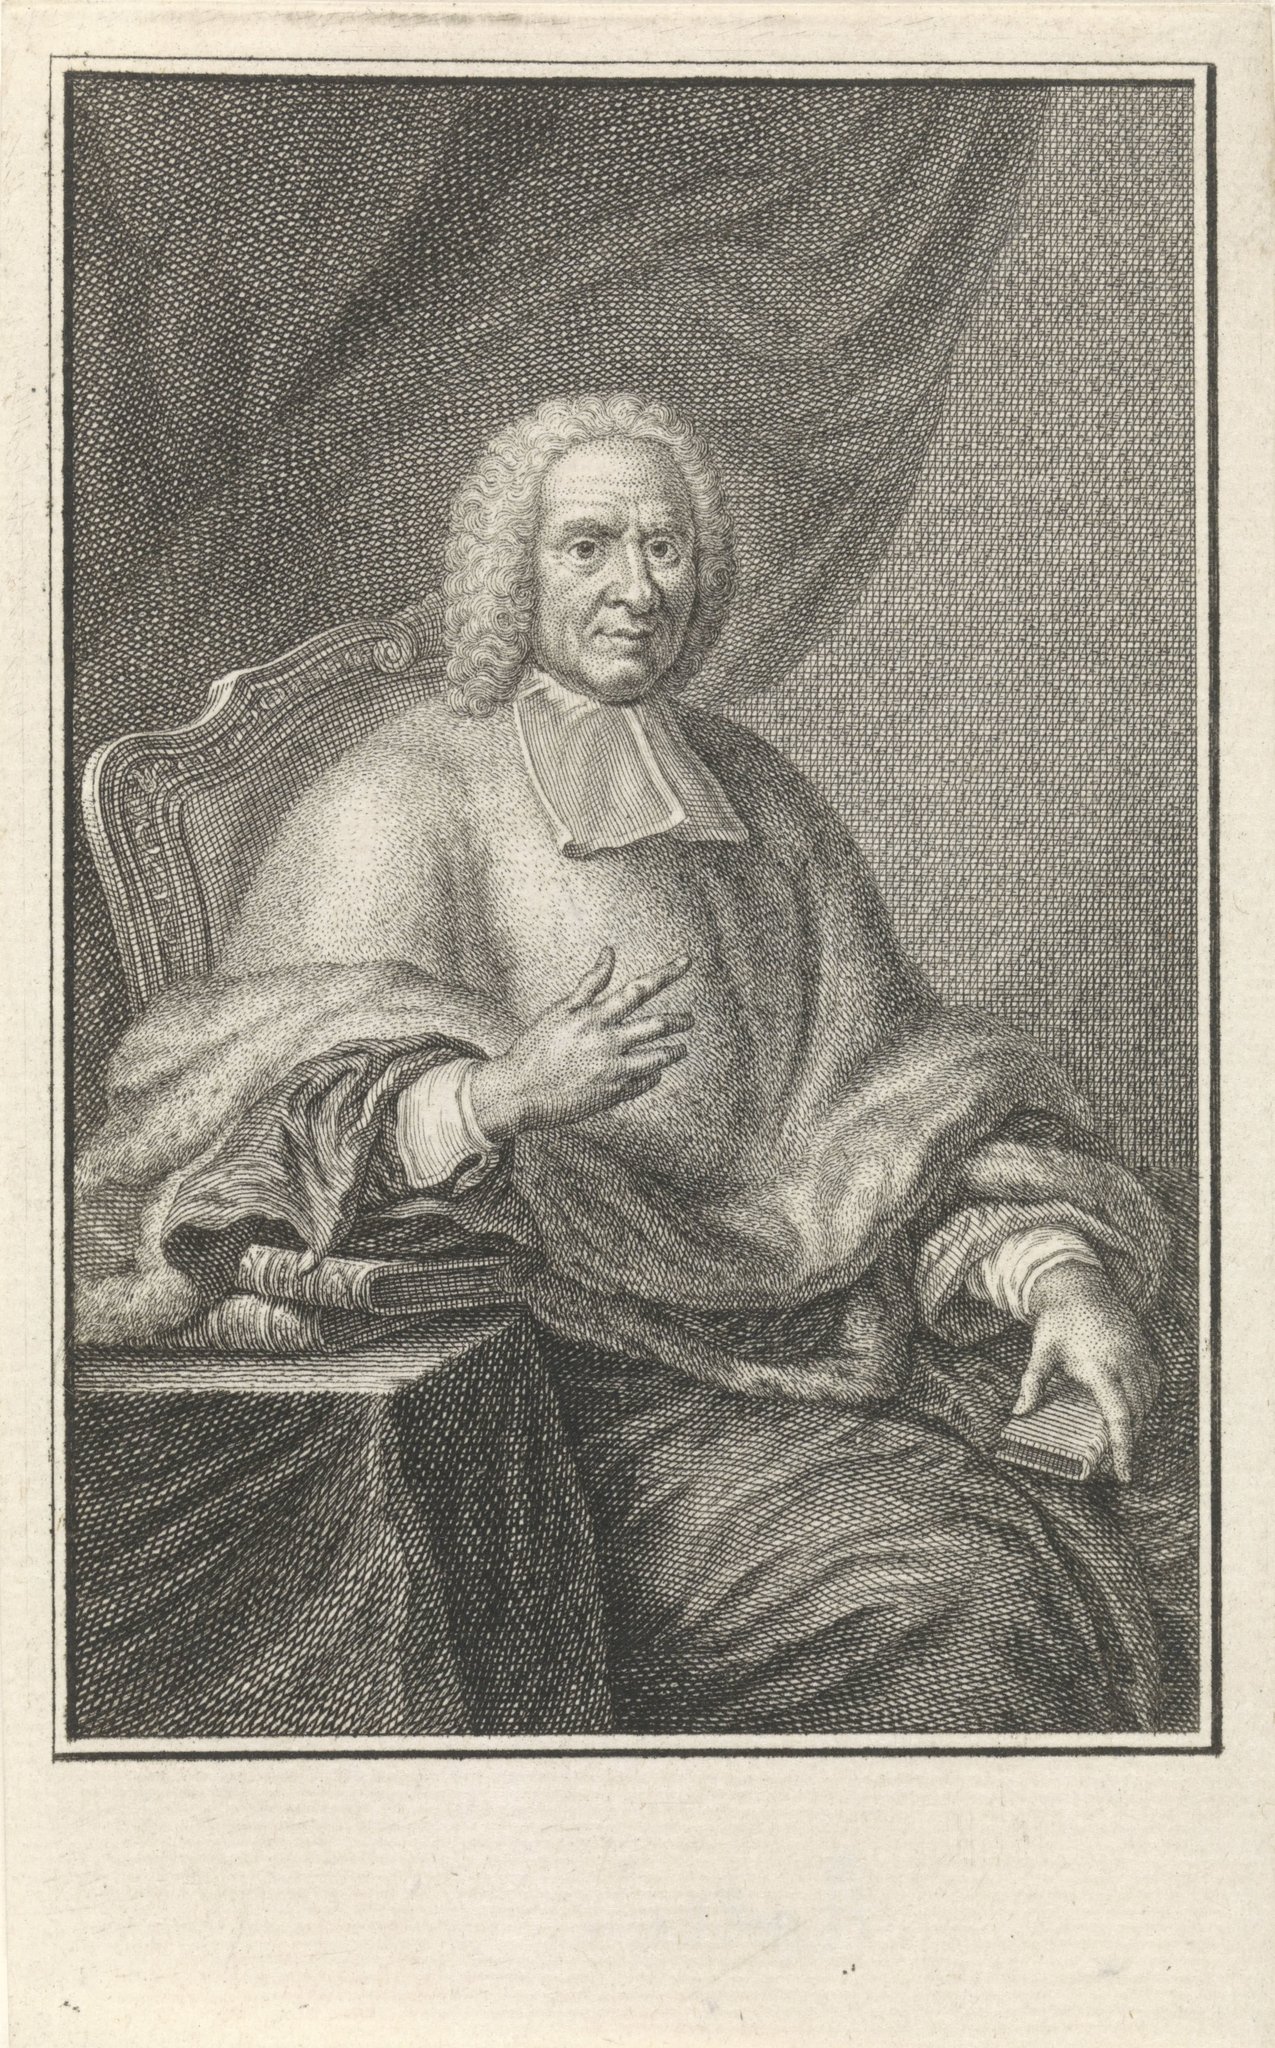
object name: print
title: Portret van Charles Rollin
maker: jacob van der schley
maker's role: draughtsman, print maker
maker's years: 1715-1779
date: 1725-1779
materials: paper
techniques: engraving, etching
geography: amsterdam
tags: paris, charles rollin, book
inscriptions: collector's mark: Lugt 2228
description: Portret van Charles Rollin, Frans historicus en professor, gezeten in een stoel met een boek in de hand.